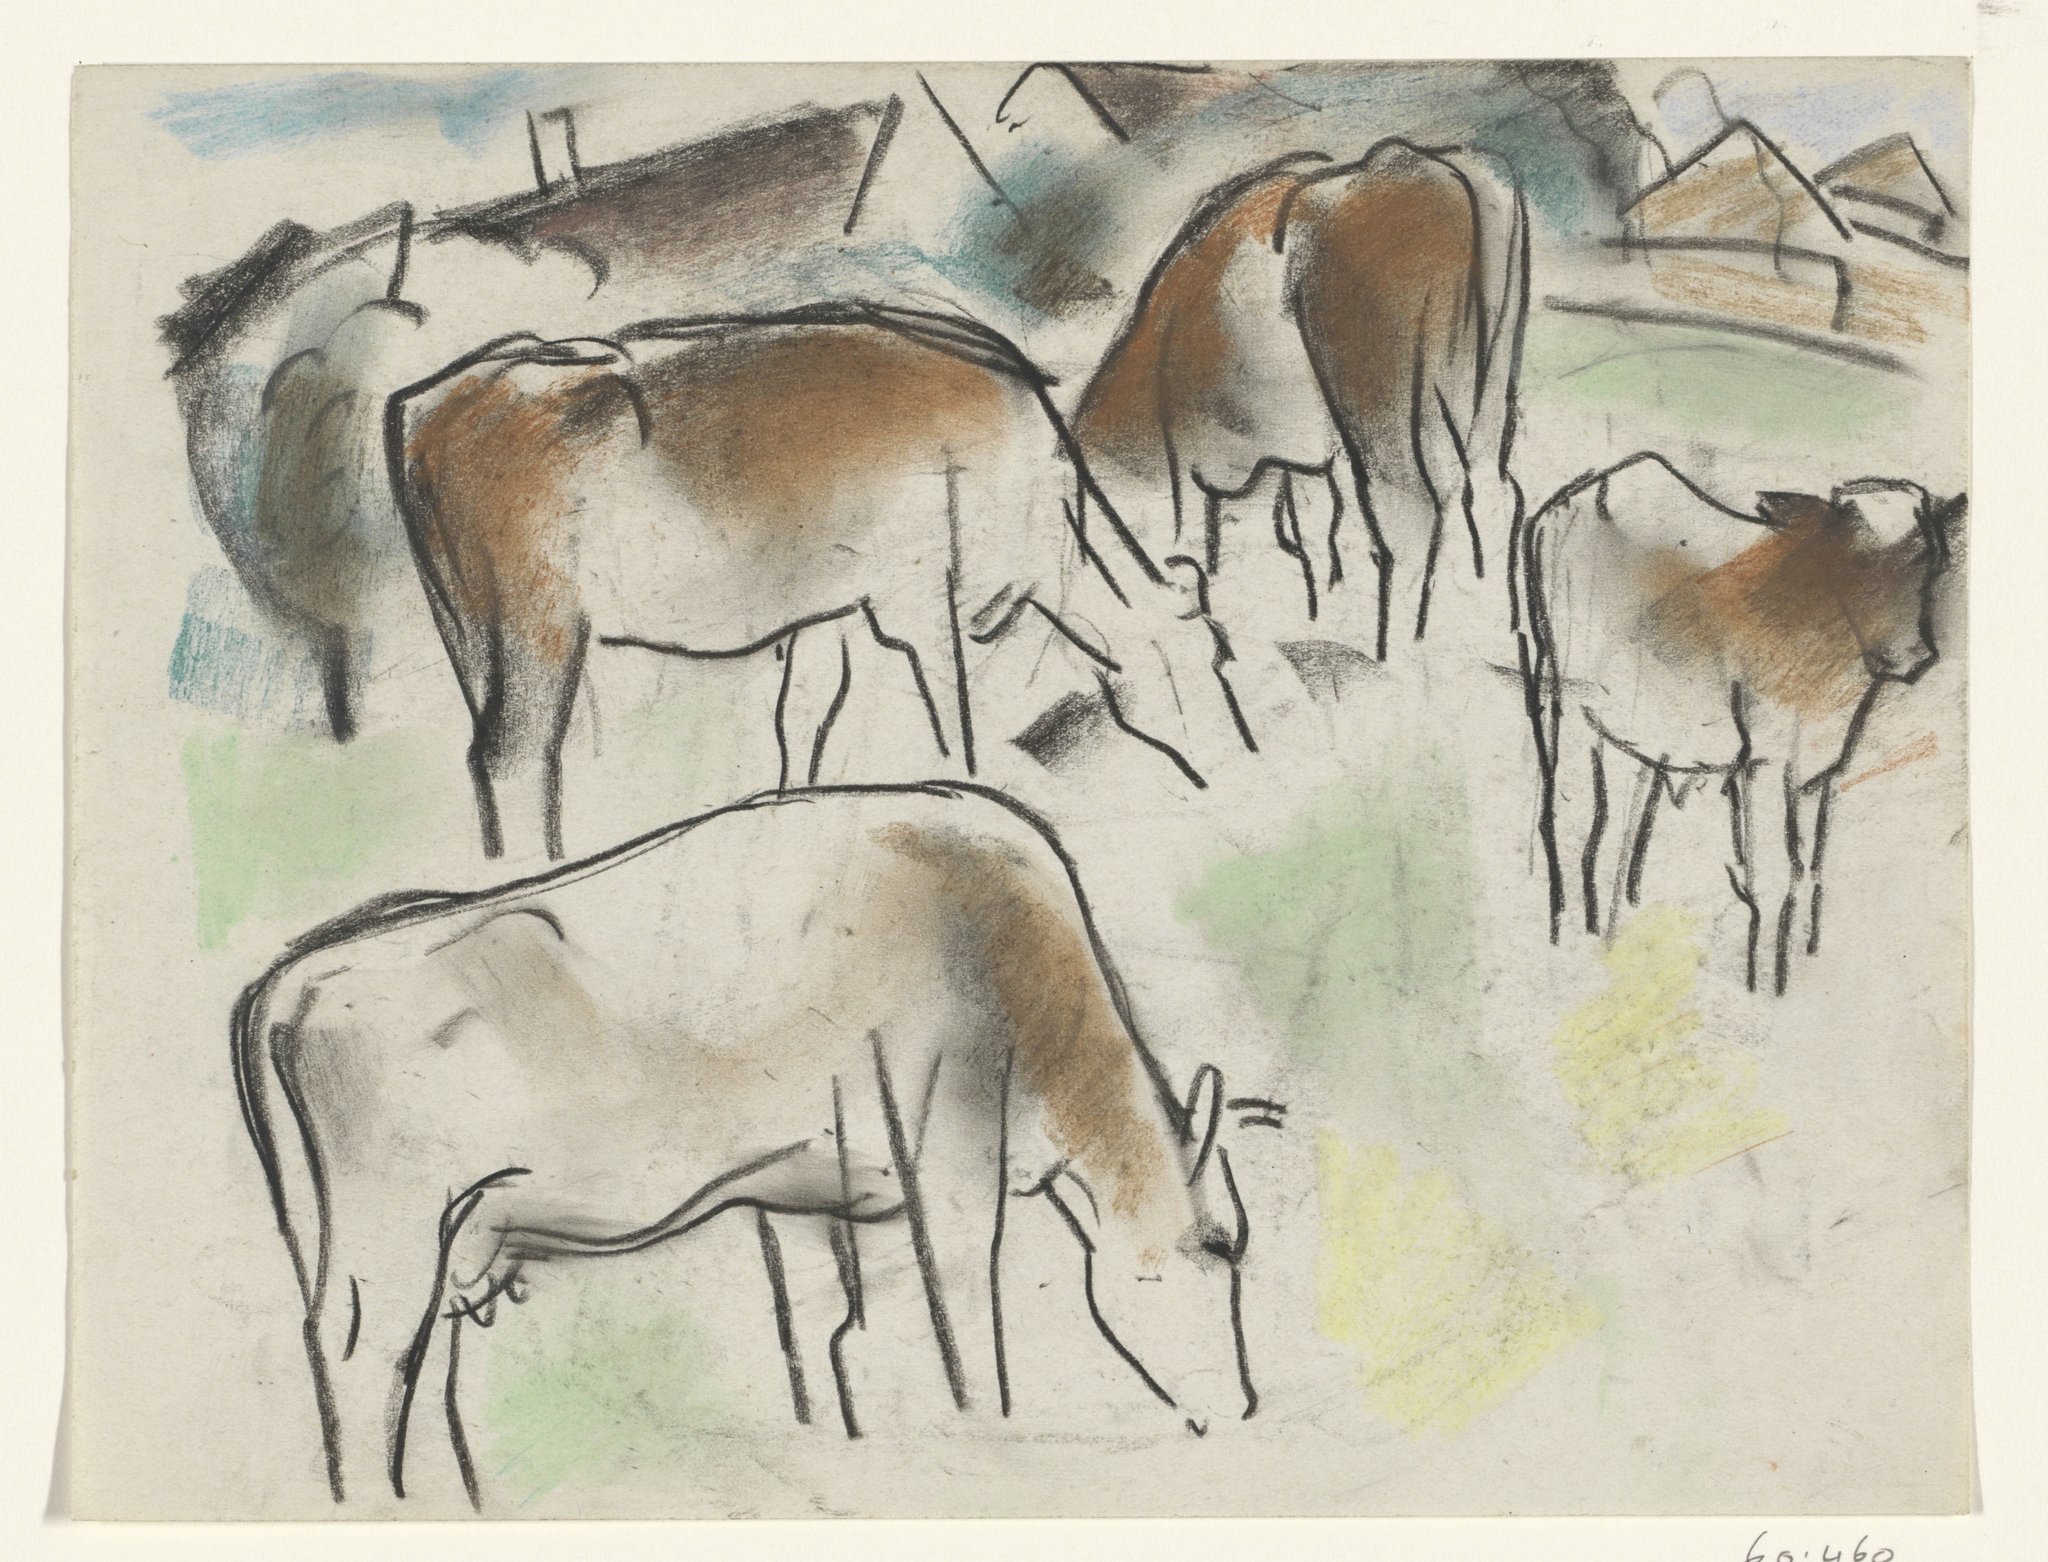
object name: drawing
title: Vier koeien in een landschap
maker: leo gestel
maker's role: draughtsman, print maker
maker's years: 1881-1941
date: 1891-1941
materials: chalk, paper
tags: cow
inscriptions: collector's mark: Lugt 2228